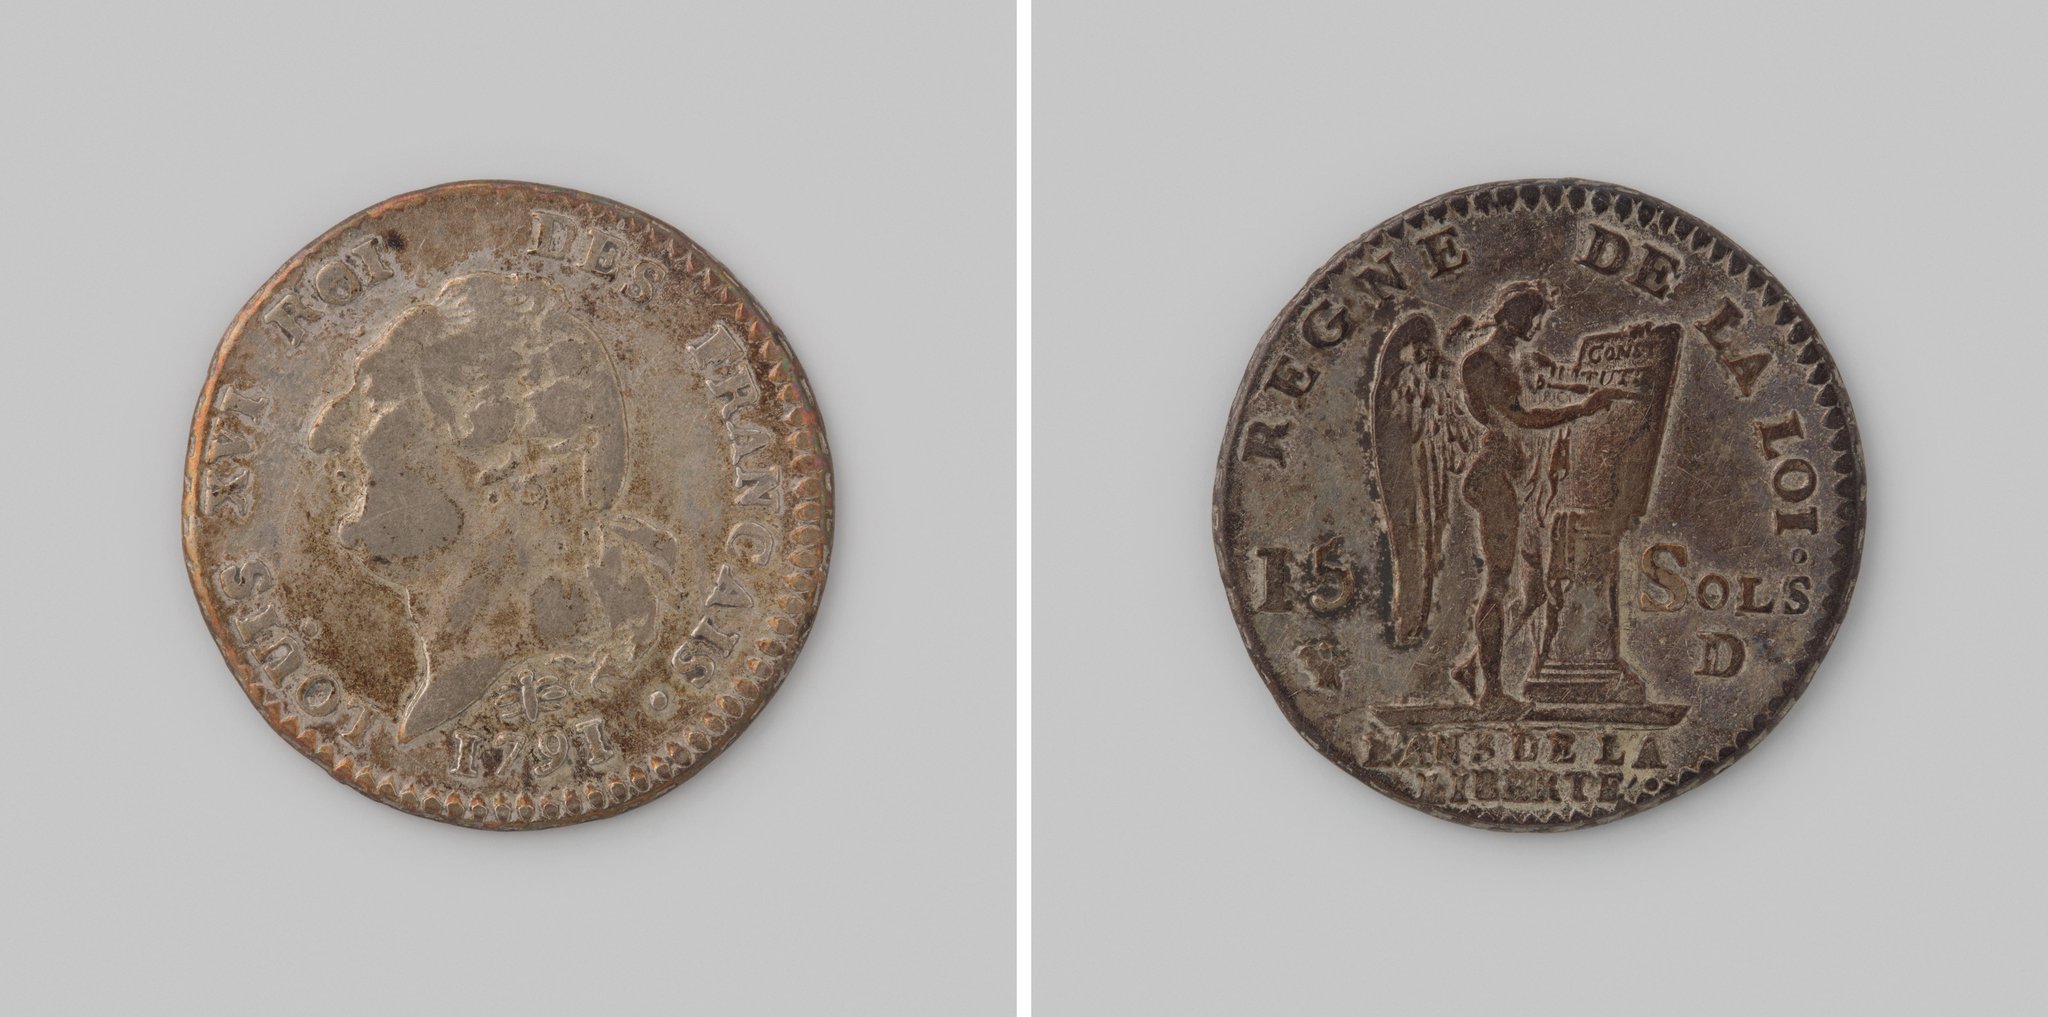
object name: coin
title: Frankrijk, 15 sols, Lodewijk XVI, 1791 D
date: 1791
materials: silver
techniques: striking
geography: lyon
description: Zilveren munt. Voorzijde: borstbeeld van de koning naar links. Daaronder jaartal. Keerzijde: tussen waarde-aanduiding gevleugelde jongeling naar rechts die op een op voetstuk staand bord in twee regels schrijft: constitution. Links en rechts van hem attributen. Uiterst rechts de letter D [=Lyon]. In afsnede jaartal 3 in nieuwe telling. Bloemrand.